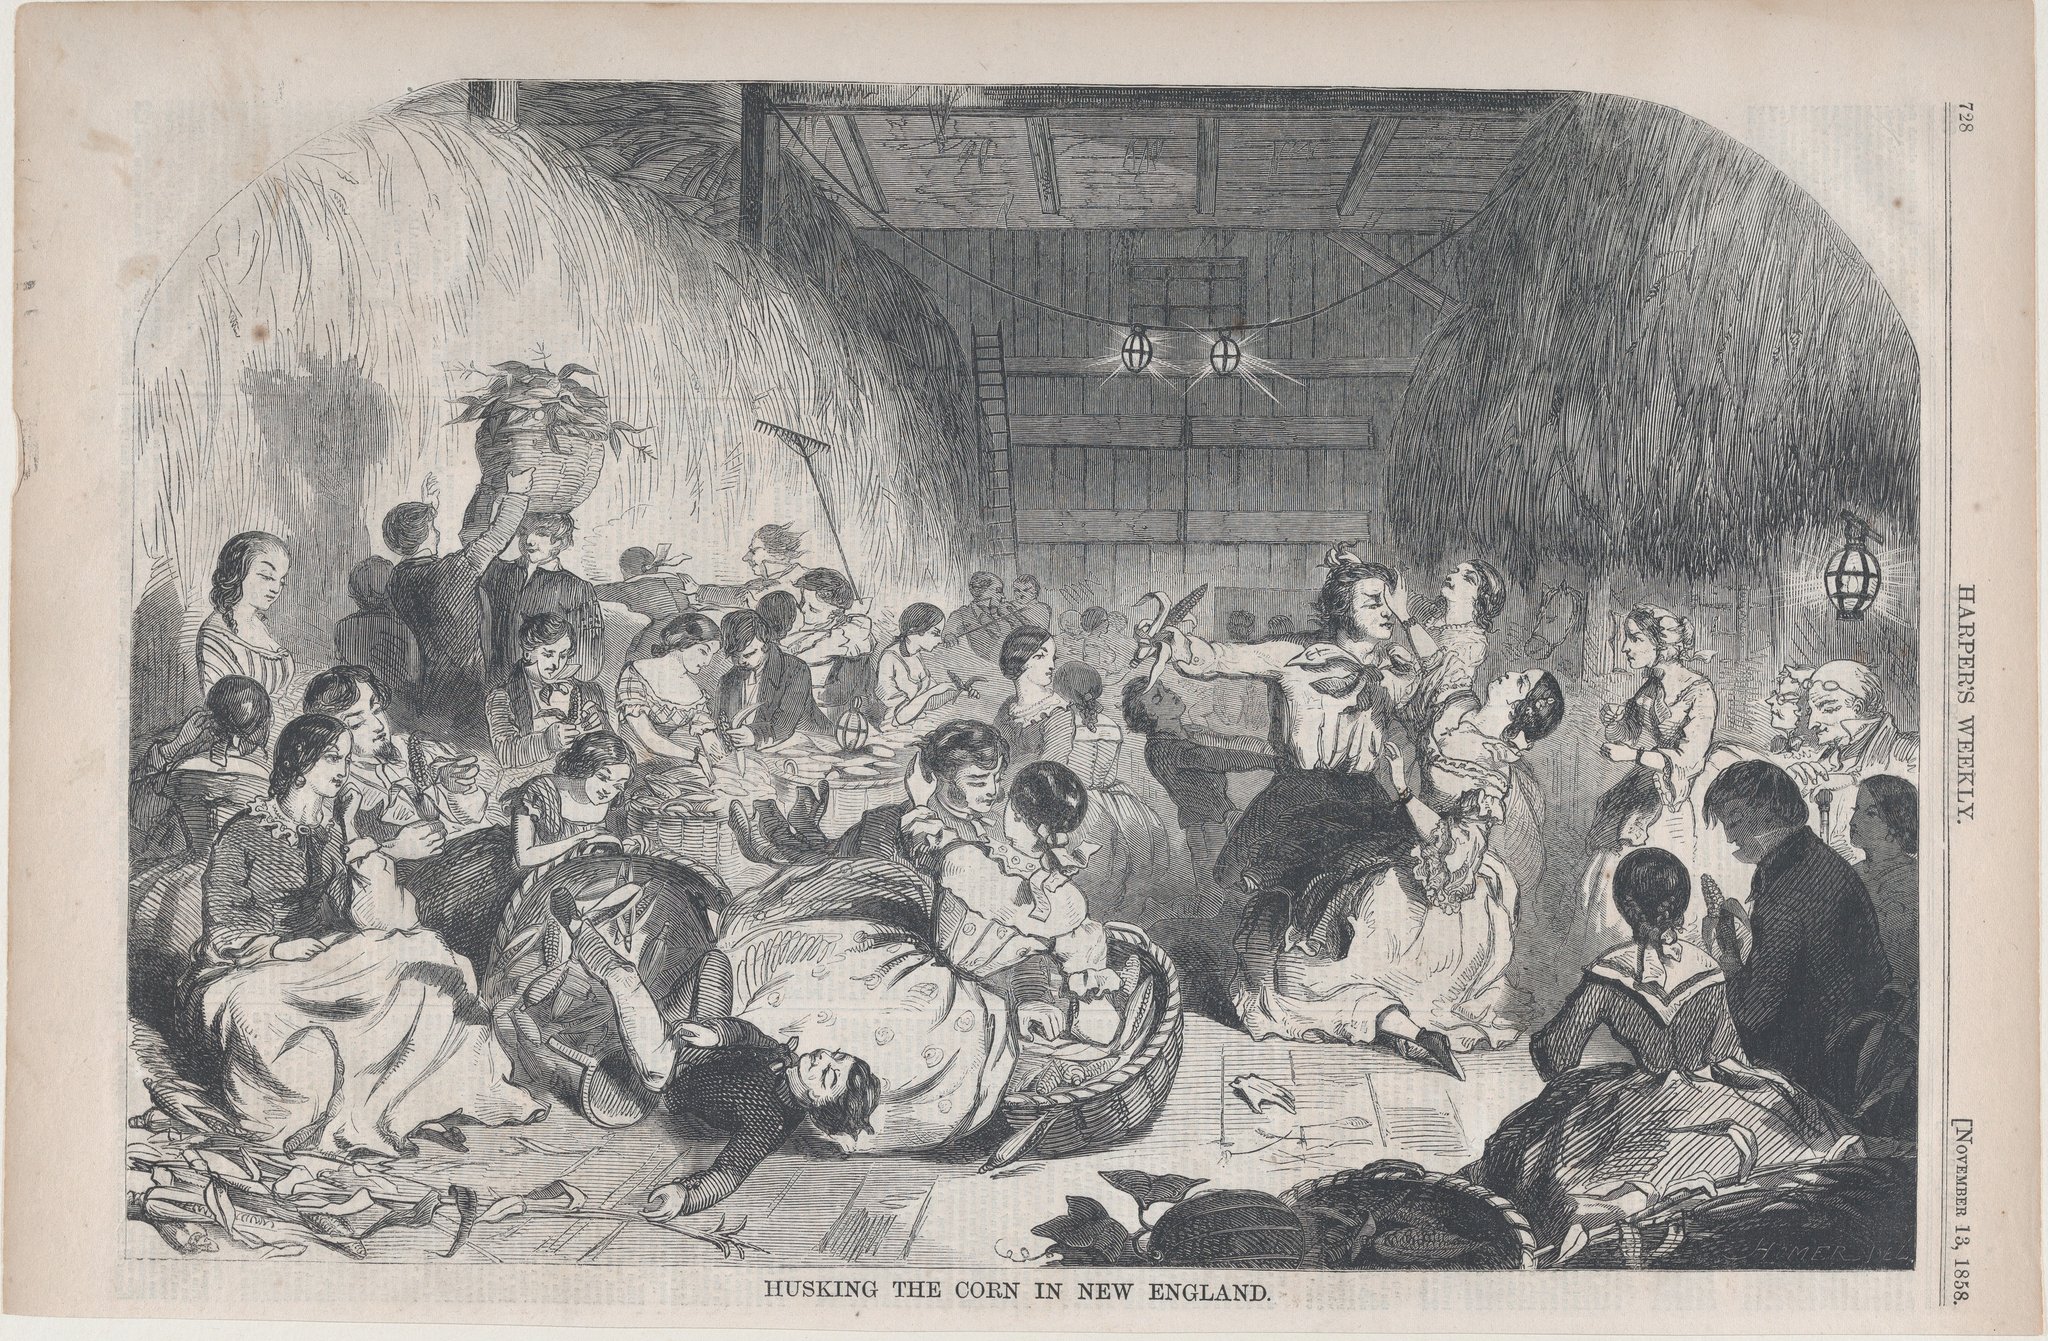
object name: print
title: Husking the Corn in New England (from "Harper's Weekly," Vol. II)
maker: winslow homer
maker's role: artist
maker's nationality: american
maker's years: 1836-1910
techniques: engraving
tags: men,women,working